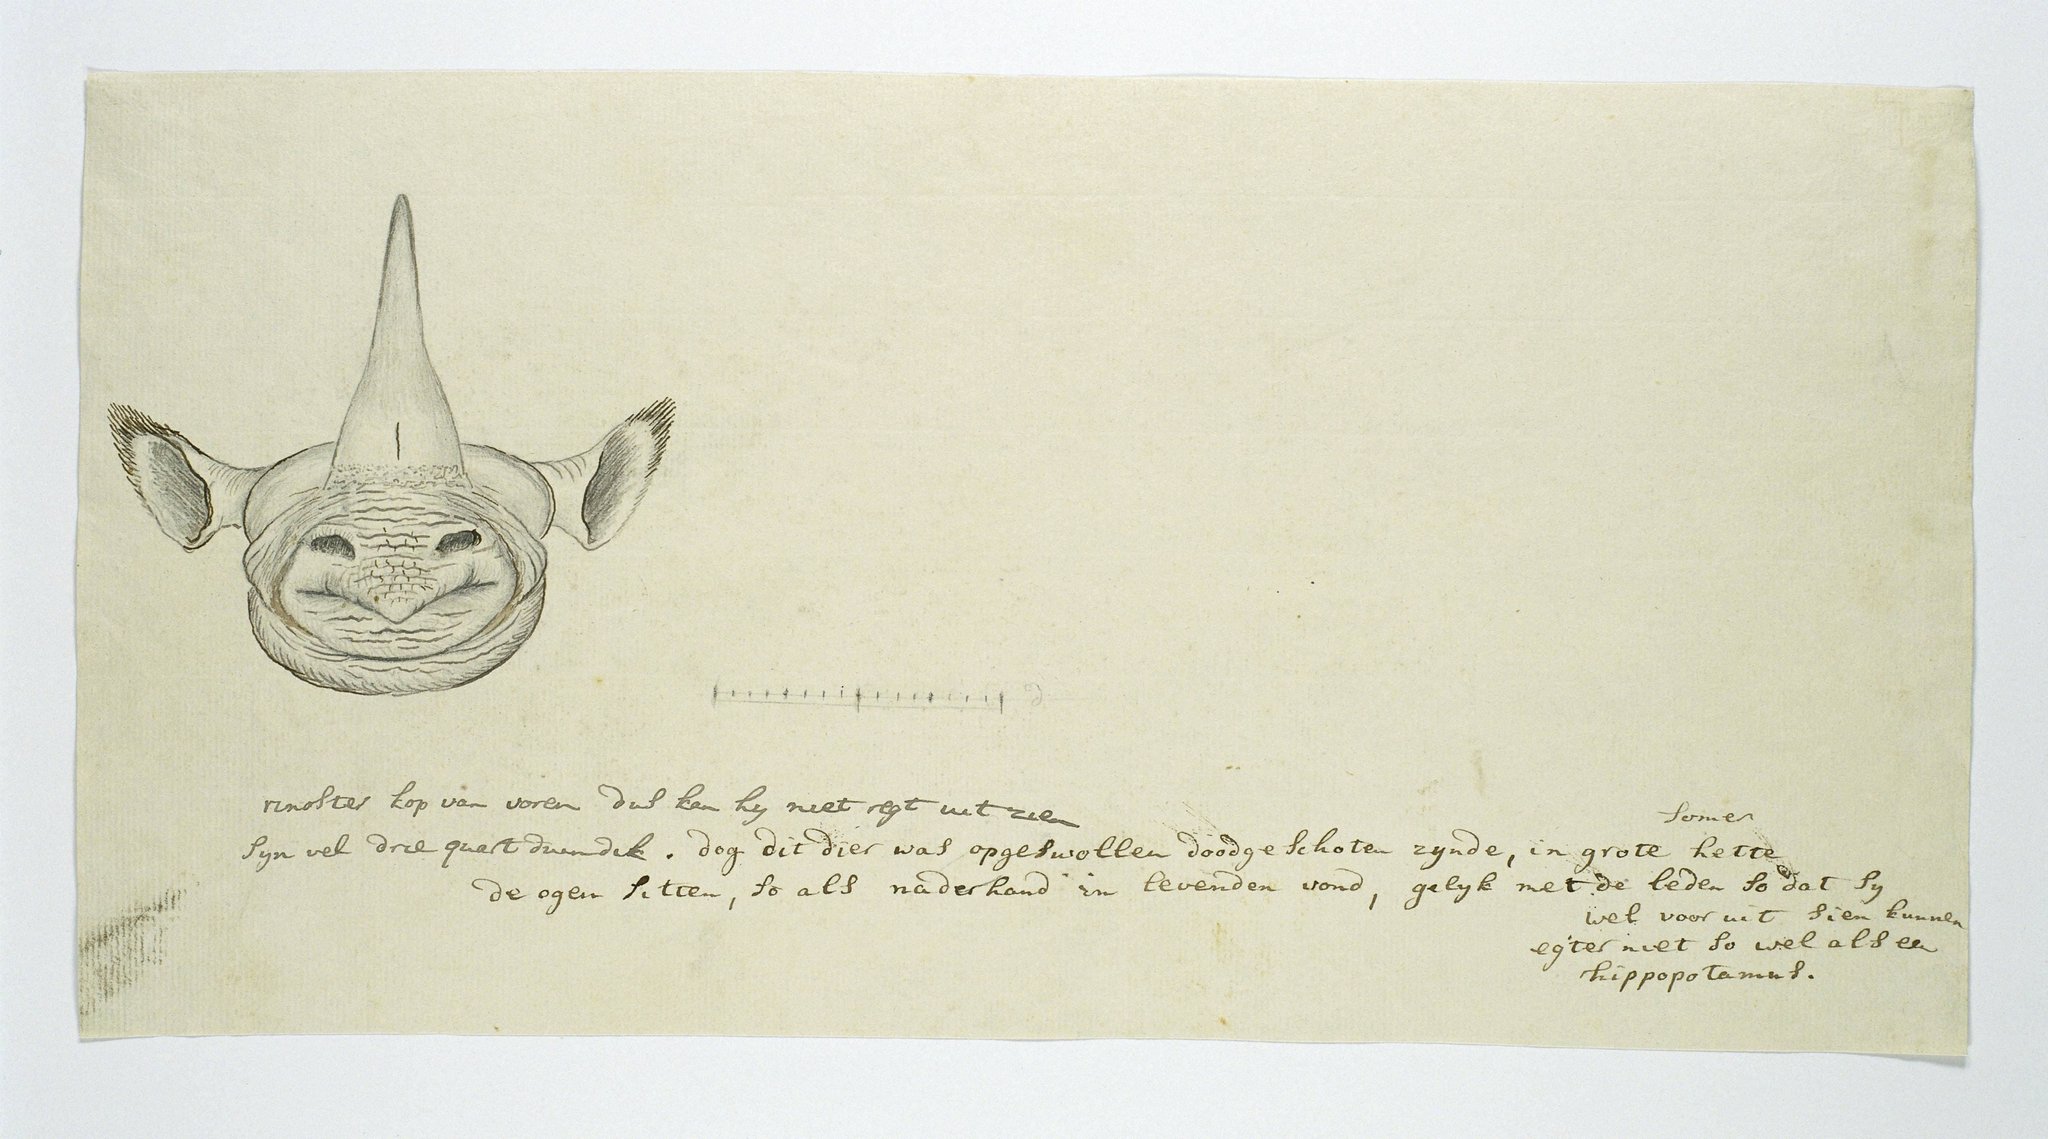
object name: album leaf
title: Diceros bicornis (Black rhinoceros)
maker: robert jacob gordon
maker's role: draughtsman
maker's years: 1743-1795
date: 1778-1779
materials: chalk, ink, paper, pencil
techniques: brush, pen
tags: hoofed animals: rhinoceros (+ head of an animal)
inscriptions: annotation: ‘rinoster kop van voren. dus kan hij niet regt uit zien. / [...]’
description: Kop van een zwarte neushoorn (Diceros bicornis), van voren; met schaalverdeling, zonder maten.